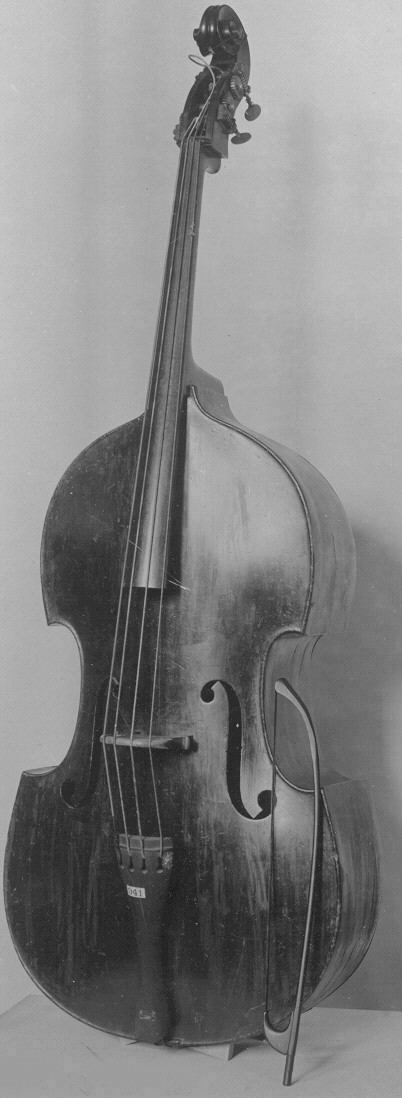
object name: double bass and bow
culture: french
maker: charles plumerel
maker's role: maker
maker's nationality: french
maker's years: 1800-1900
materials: brass, wood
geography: france